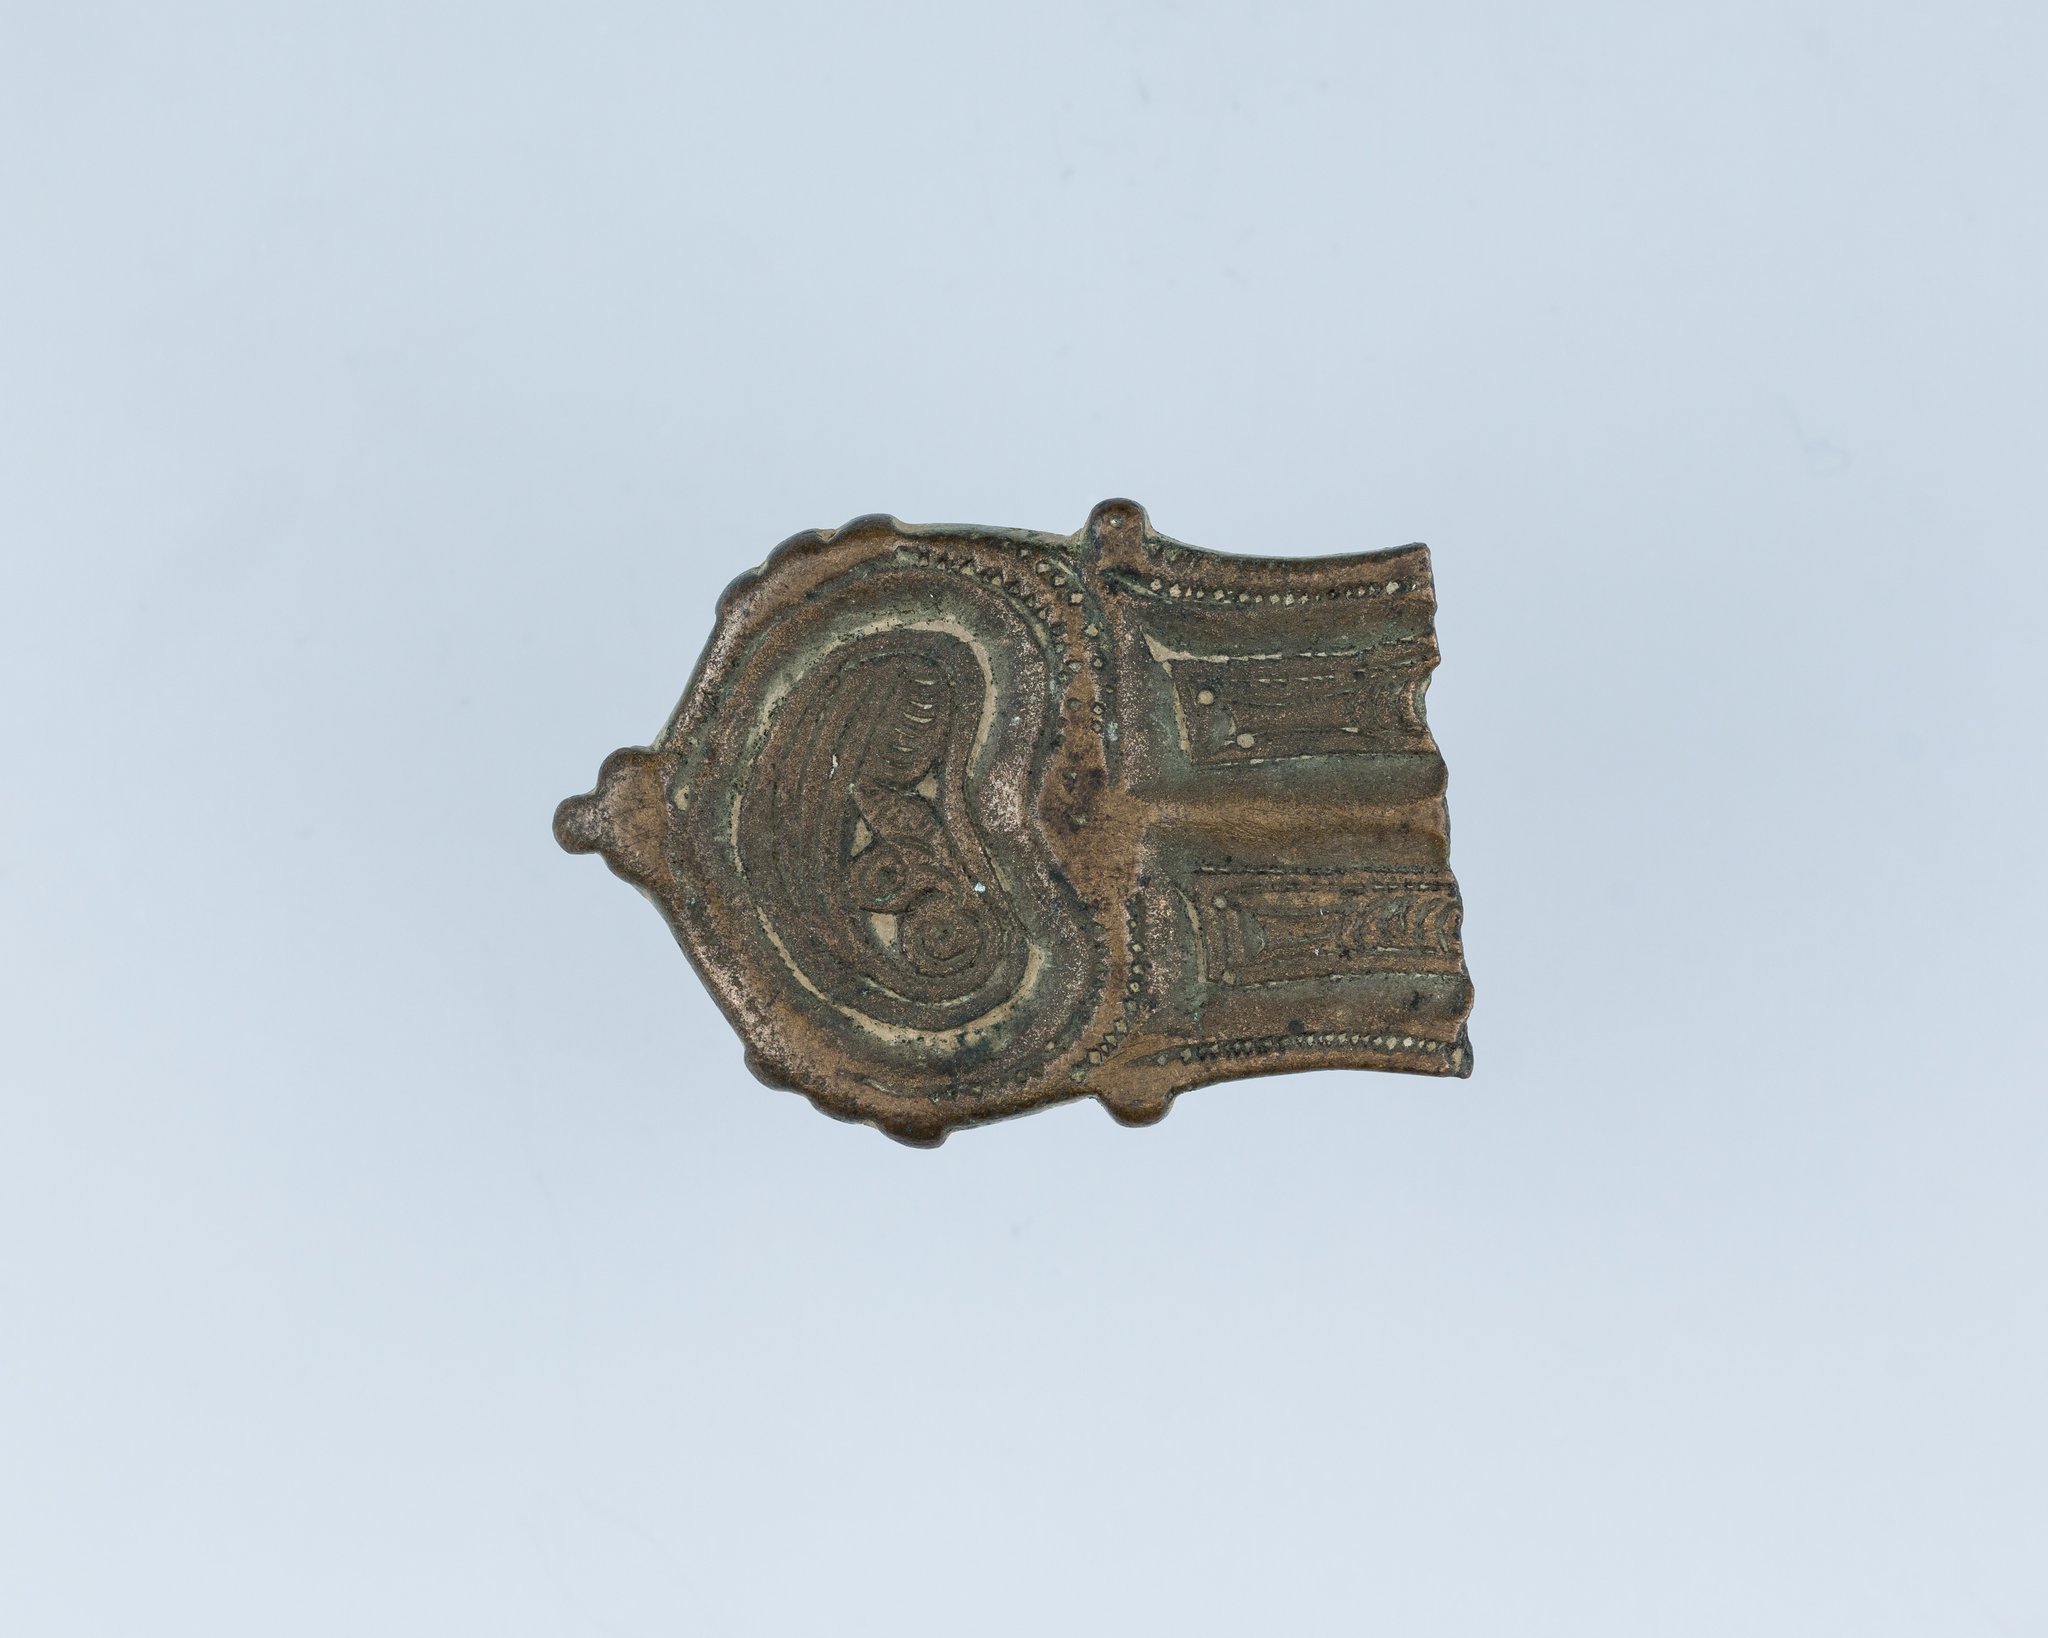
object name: buckle shank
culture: visigothic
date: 401-700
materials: bronze